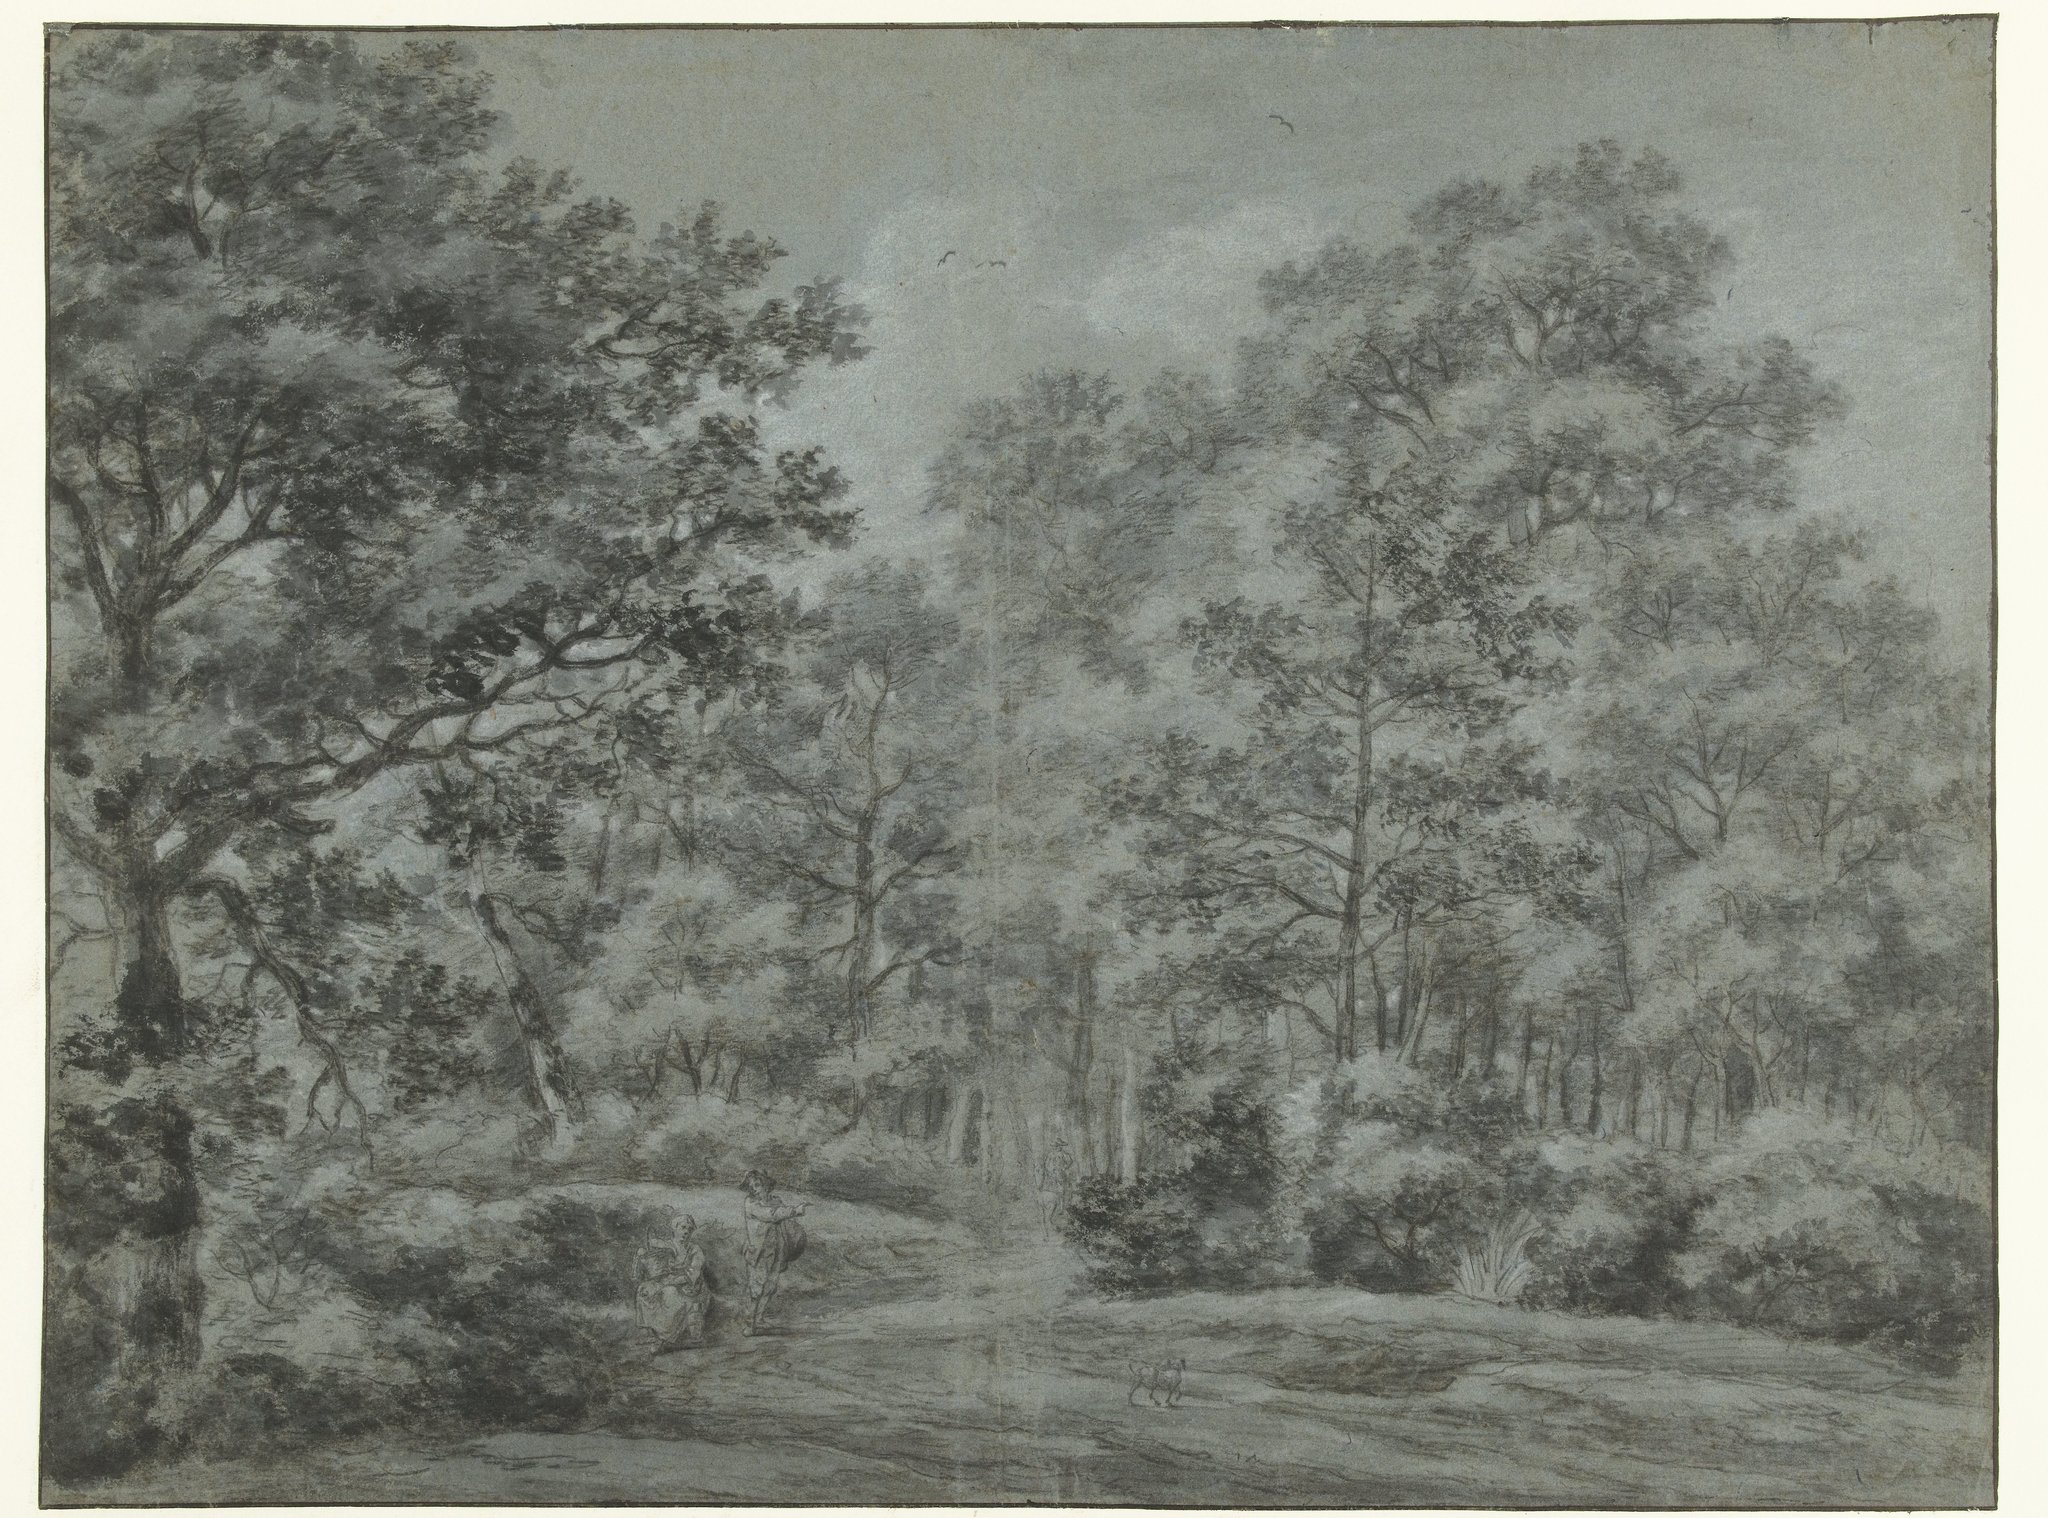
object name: drawing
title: Bosgezicht met enkele figuren langs een pad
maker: simon de vlieger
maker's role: draughtsman, painter, print maker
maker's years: 1600-1653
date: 1610-1653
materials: chalk, paper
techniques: brush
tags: forest, wood